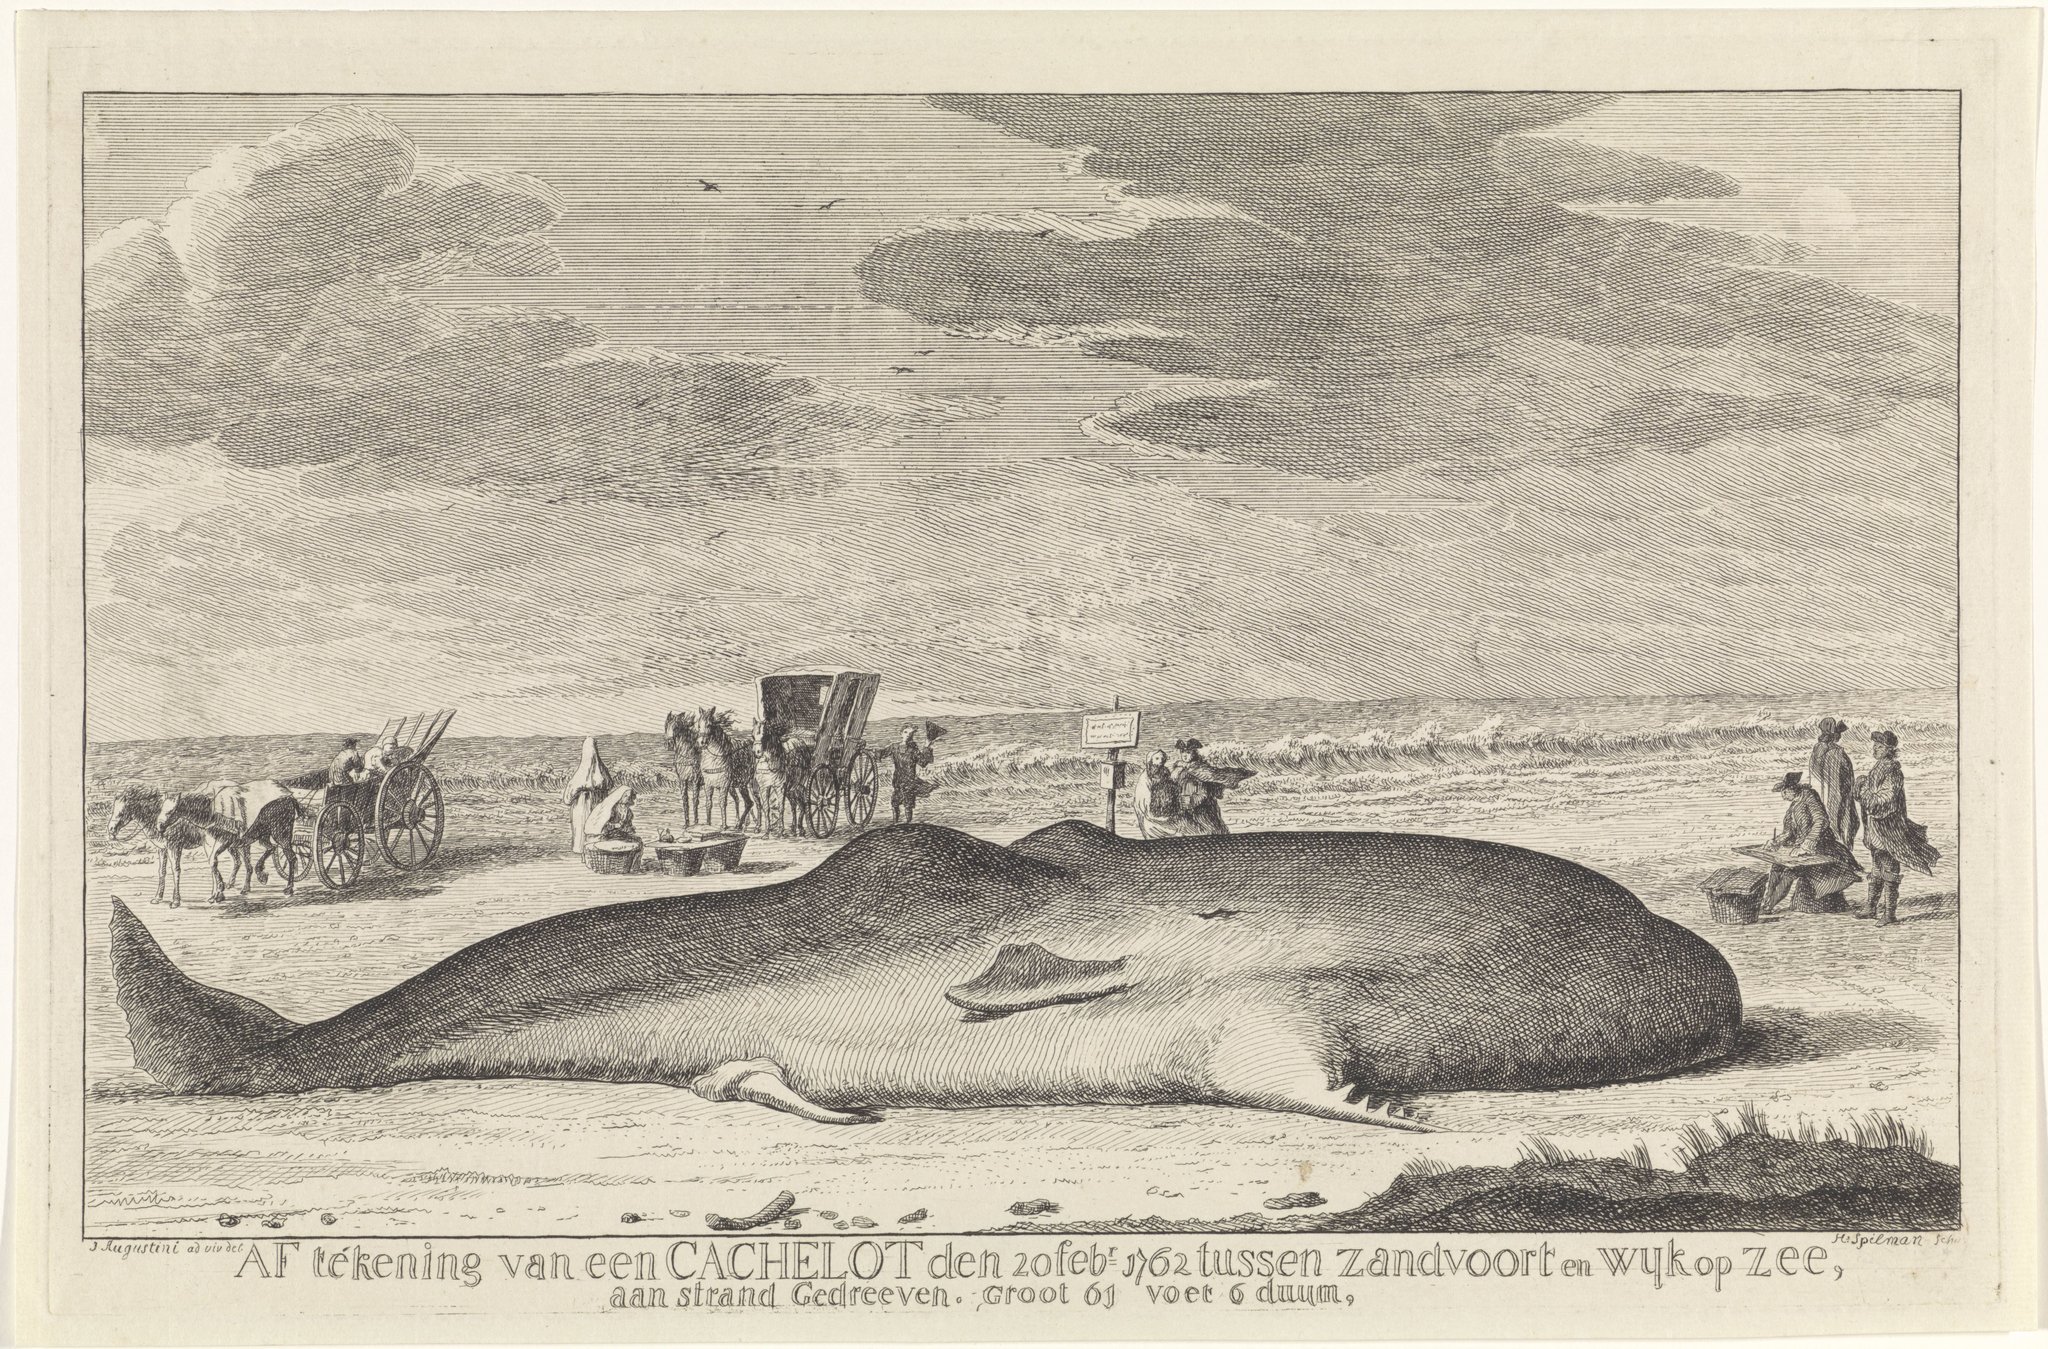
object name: print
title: Aftekening van een cachelot den 20febr 1762 tussen Zandvoort en Wyk op Zee, aan strand gedreeven groot 61 voet 6 duum.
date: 1762-1764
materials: paper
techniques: etching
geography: haarlem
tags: four-wheeled, animal-drawn vehicle, e.g.: cab, carriage, coach, swimming mammals: whale (+ dying animal; death of animal; dead animal), draughtsman at work - cc - out of doors, selling, (farm) wagon, freight wagon, cart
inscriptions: collector's mark: Lugt 2228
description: Op een strand ligt een aangespoelde potvis. Rechts een tekenaar, links een boerenkar en een koets, een verkoopster en in het midden een toekijkend paar.